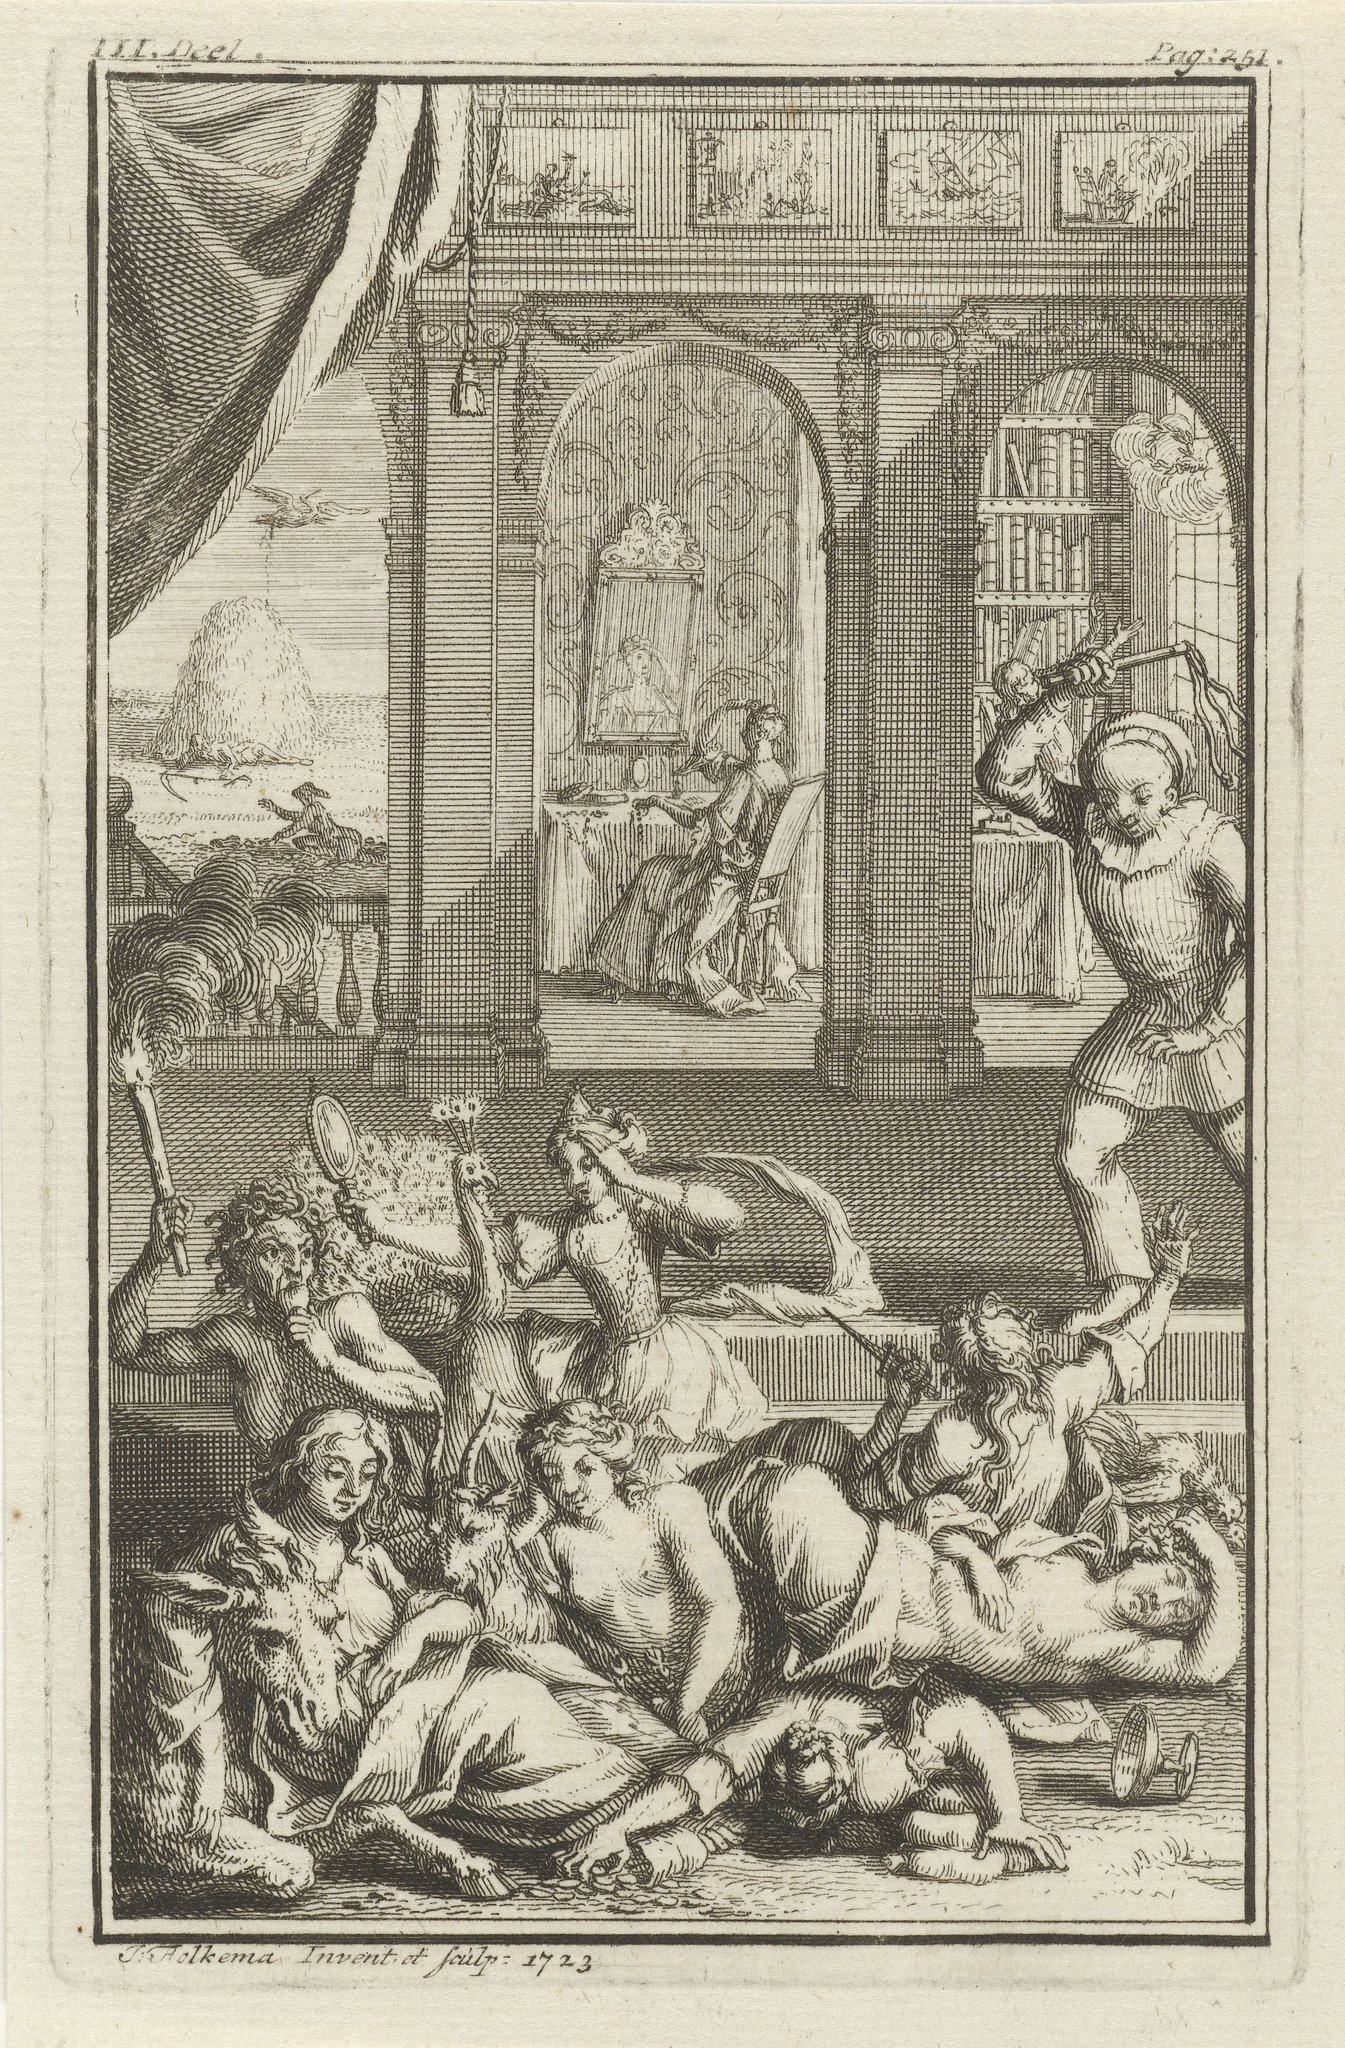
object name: print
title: Titelpagina voor: R. van Leuve, Mengelwerken, 1723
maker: jacob folkema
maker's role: draughtsman, print maker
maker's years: 1692-1767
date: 1723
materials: paper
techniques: etching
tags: whip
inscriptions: collector's mark: Lugt 2228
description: Rechts staat een man die met zijn zweep een aantal mannen, vrouwen en dieren bijeen heeft gedreven. Een duivels figuur met slangenharen en een brandende toorts staat samen met de gepersonifieerde Hoogmoed achter deze groep figuren. Prent links- en rechtsboven gemerkt: III Deel - Pag. 251.